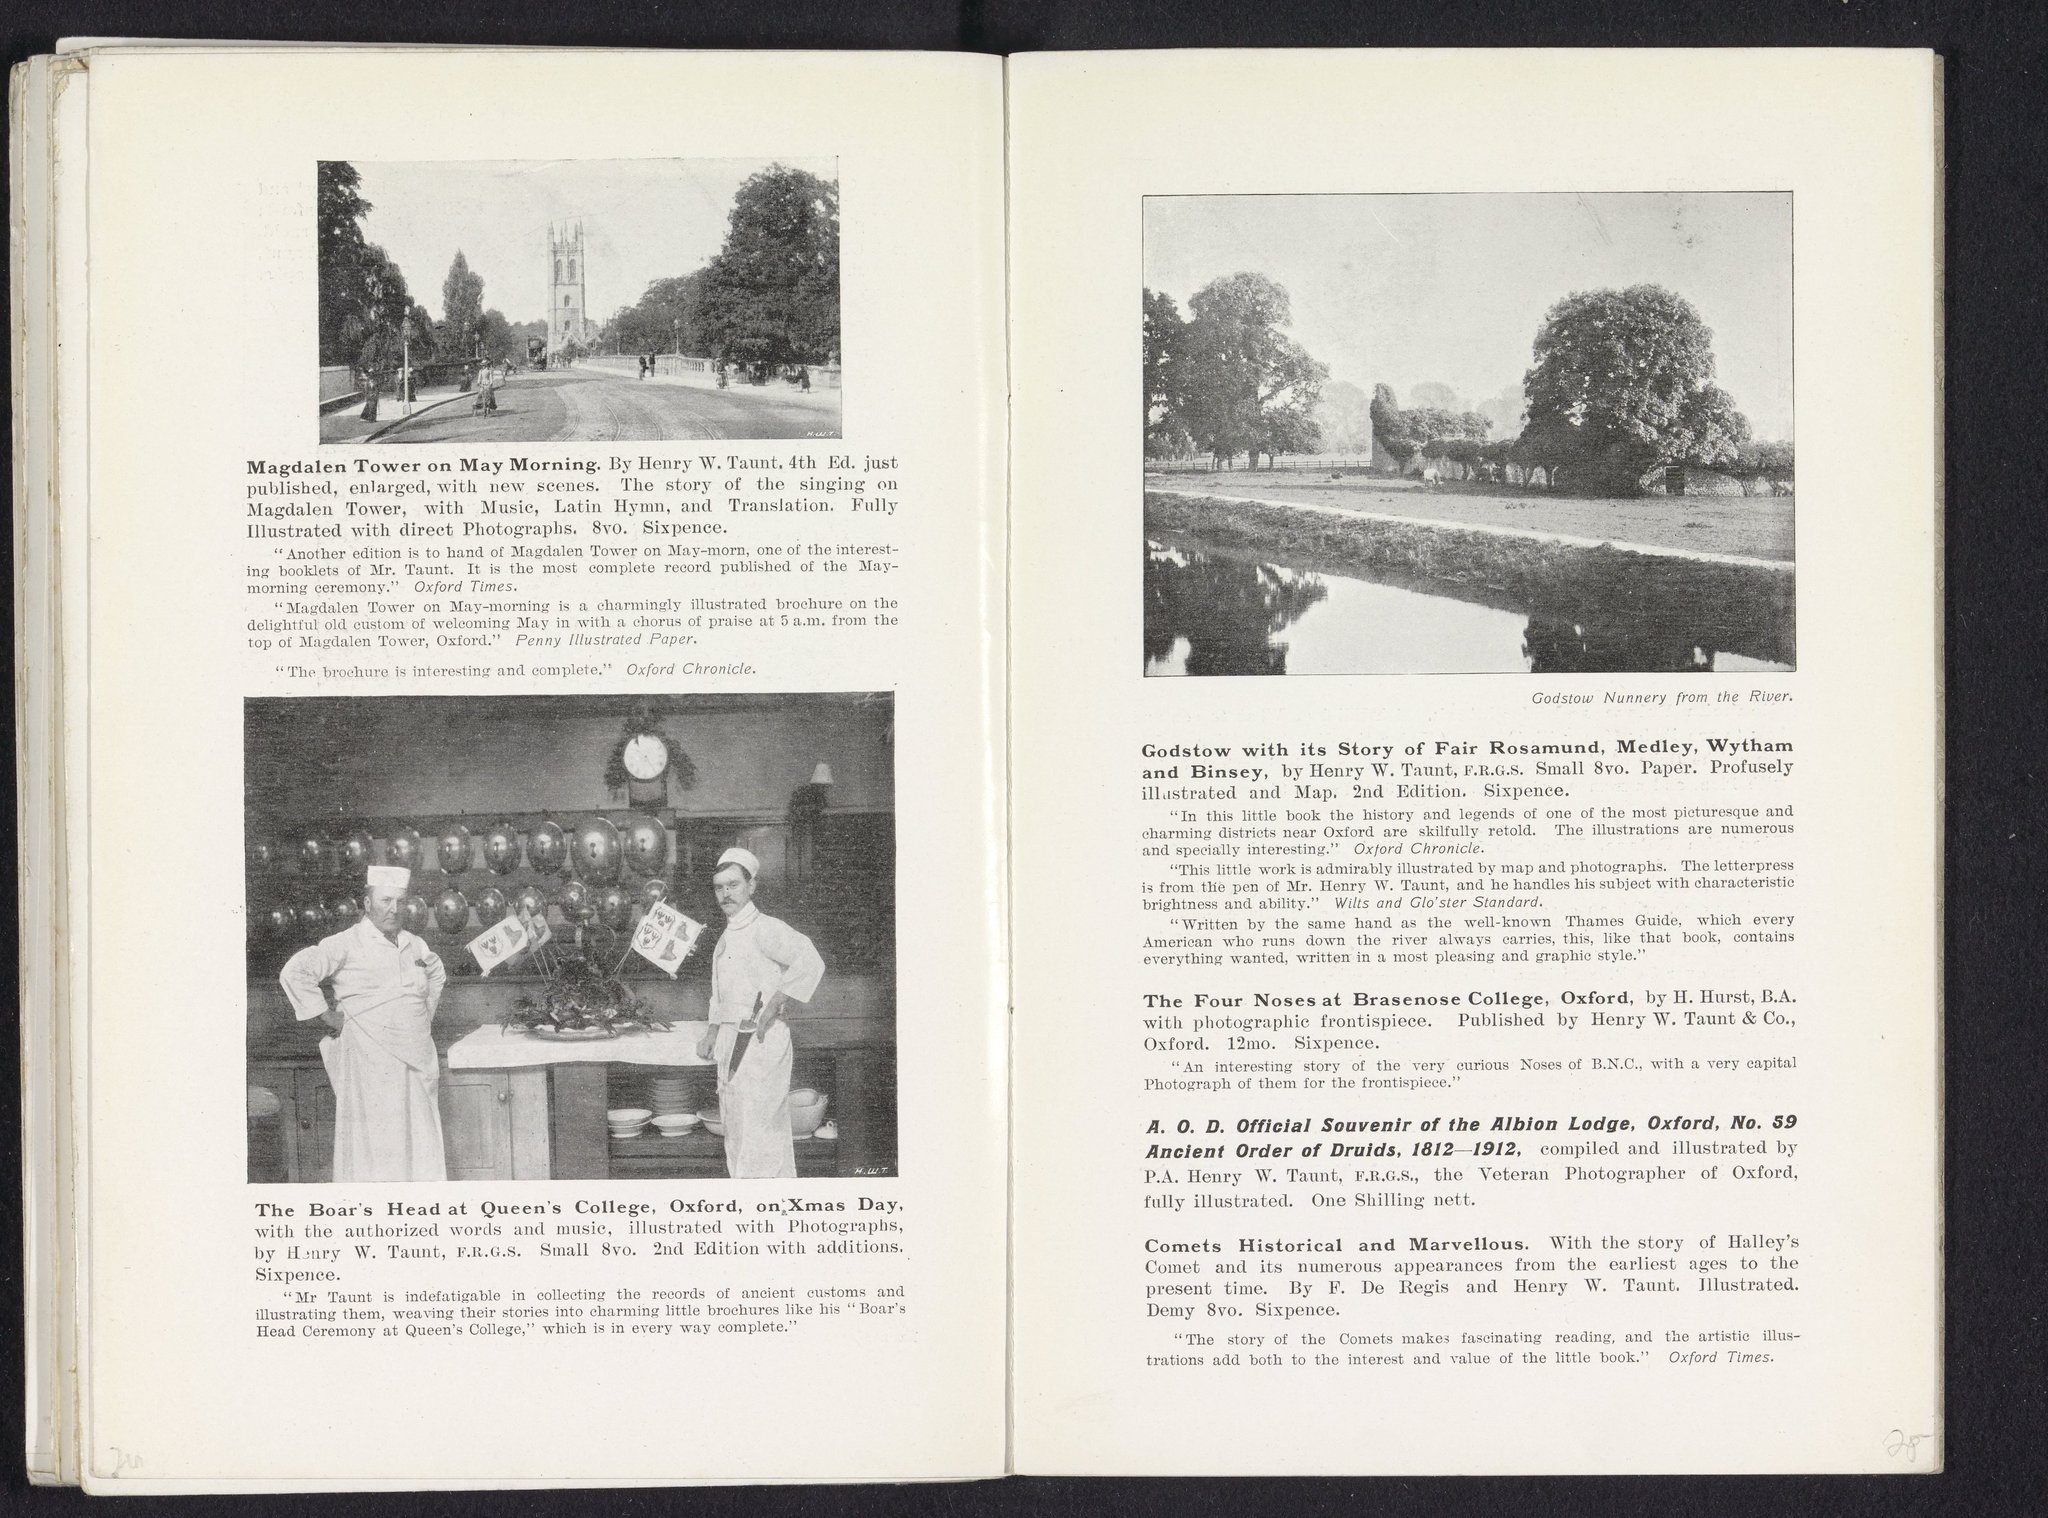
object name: photomechanical print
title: Magdalen Tower on May morning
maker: henry w. taunt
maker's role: fotograaf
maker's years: 1842-1922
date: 1907-1912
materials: paper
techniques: autotype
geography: oxford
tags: tower, clock tower ~ monumental adornment, 25f24(boar)(+33) hoofed animals: boar (+ head of an animal), cook